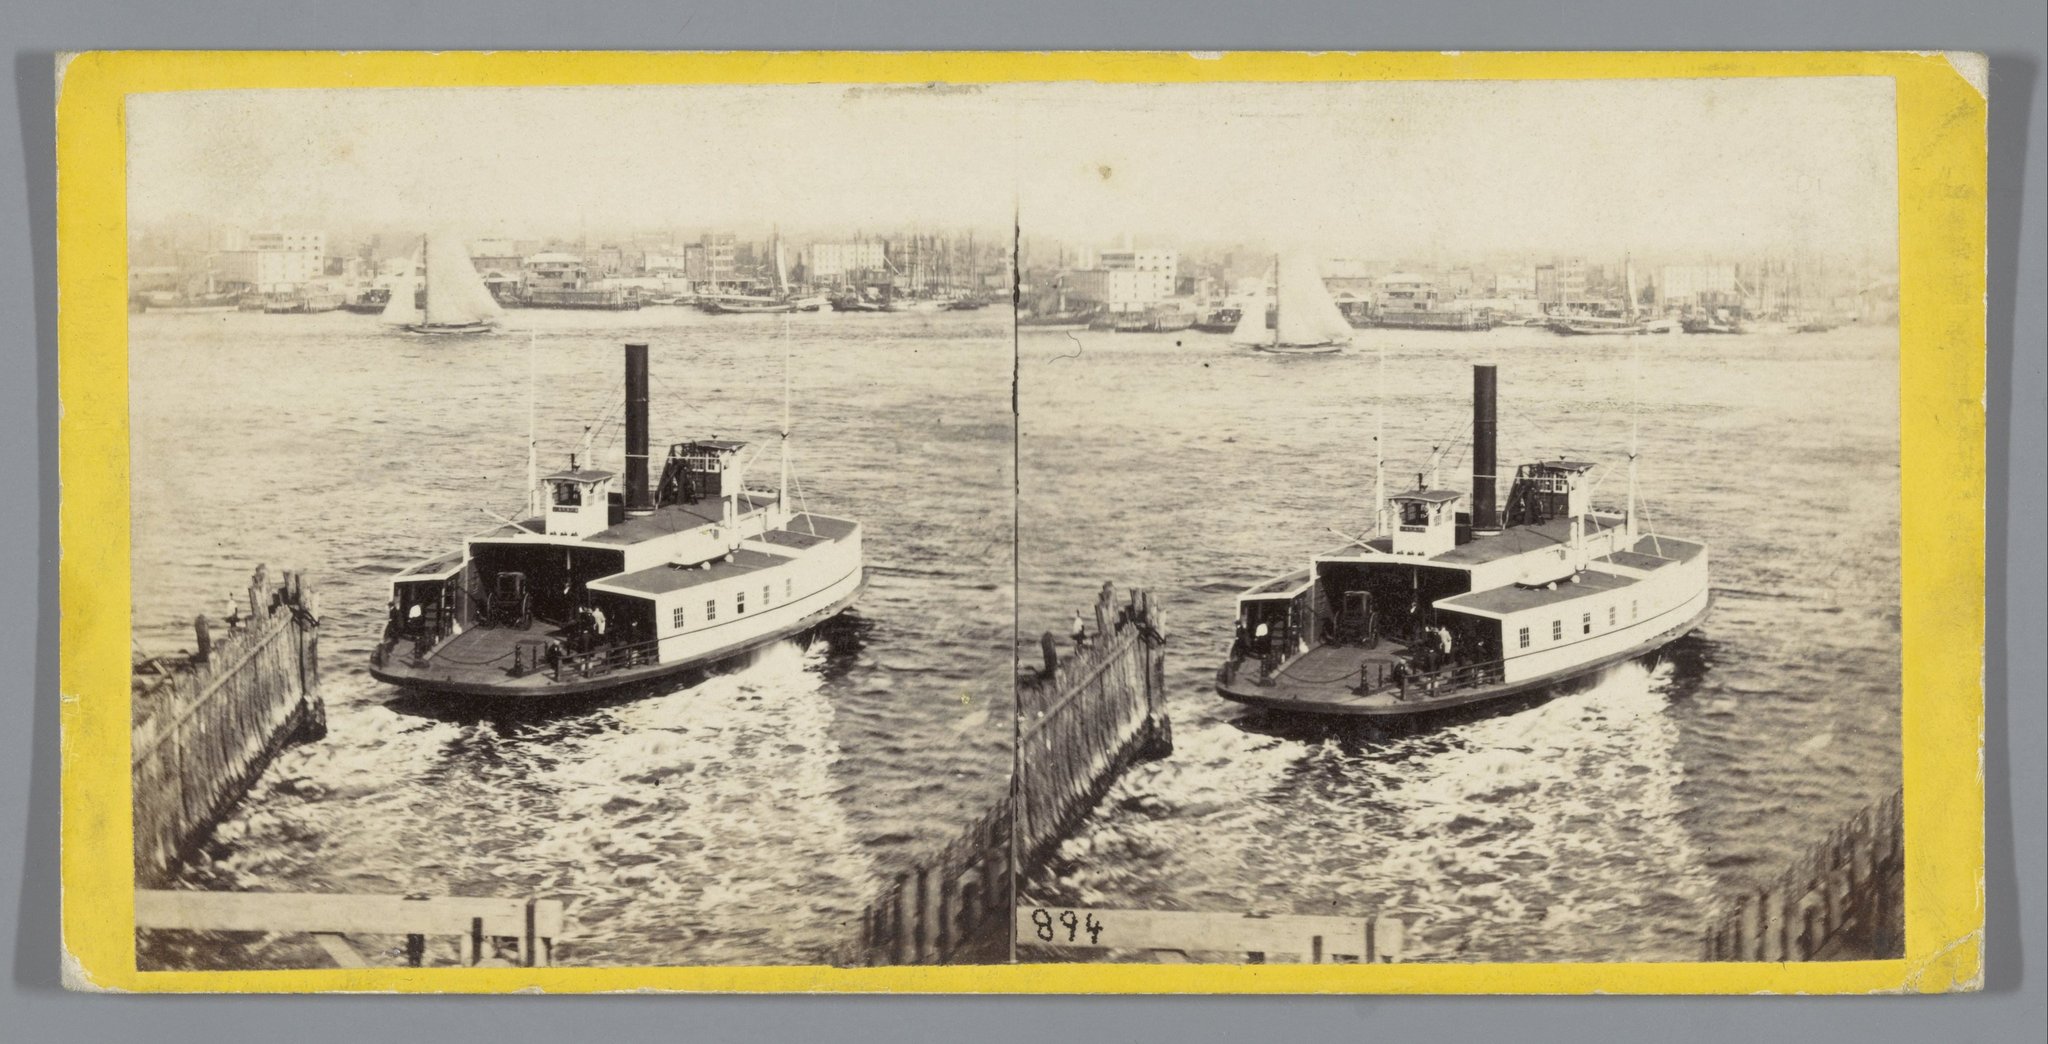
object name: stereograph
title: Anthony's Instantaneous Views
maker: Anonymous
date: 1864-1866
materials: cardboard, paper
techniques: albumen print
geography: new york city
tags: ferry, new york (city)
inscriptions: seal: ‘Proprietary 2 Cents’, number: ‘894’, address: ‘American and Foreign Stereoscopic Emporium, 501 Broadway, New-York.’